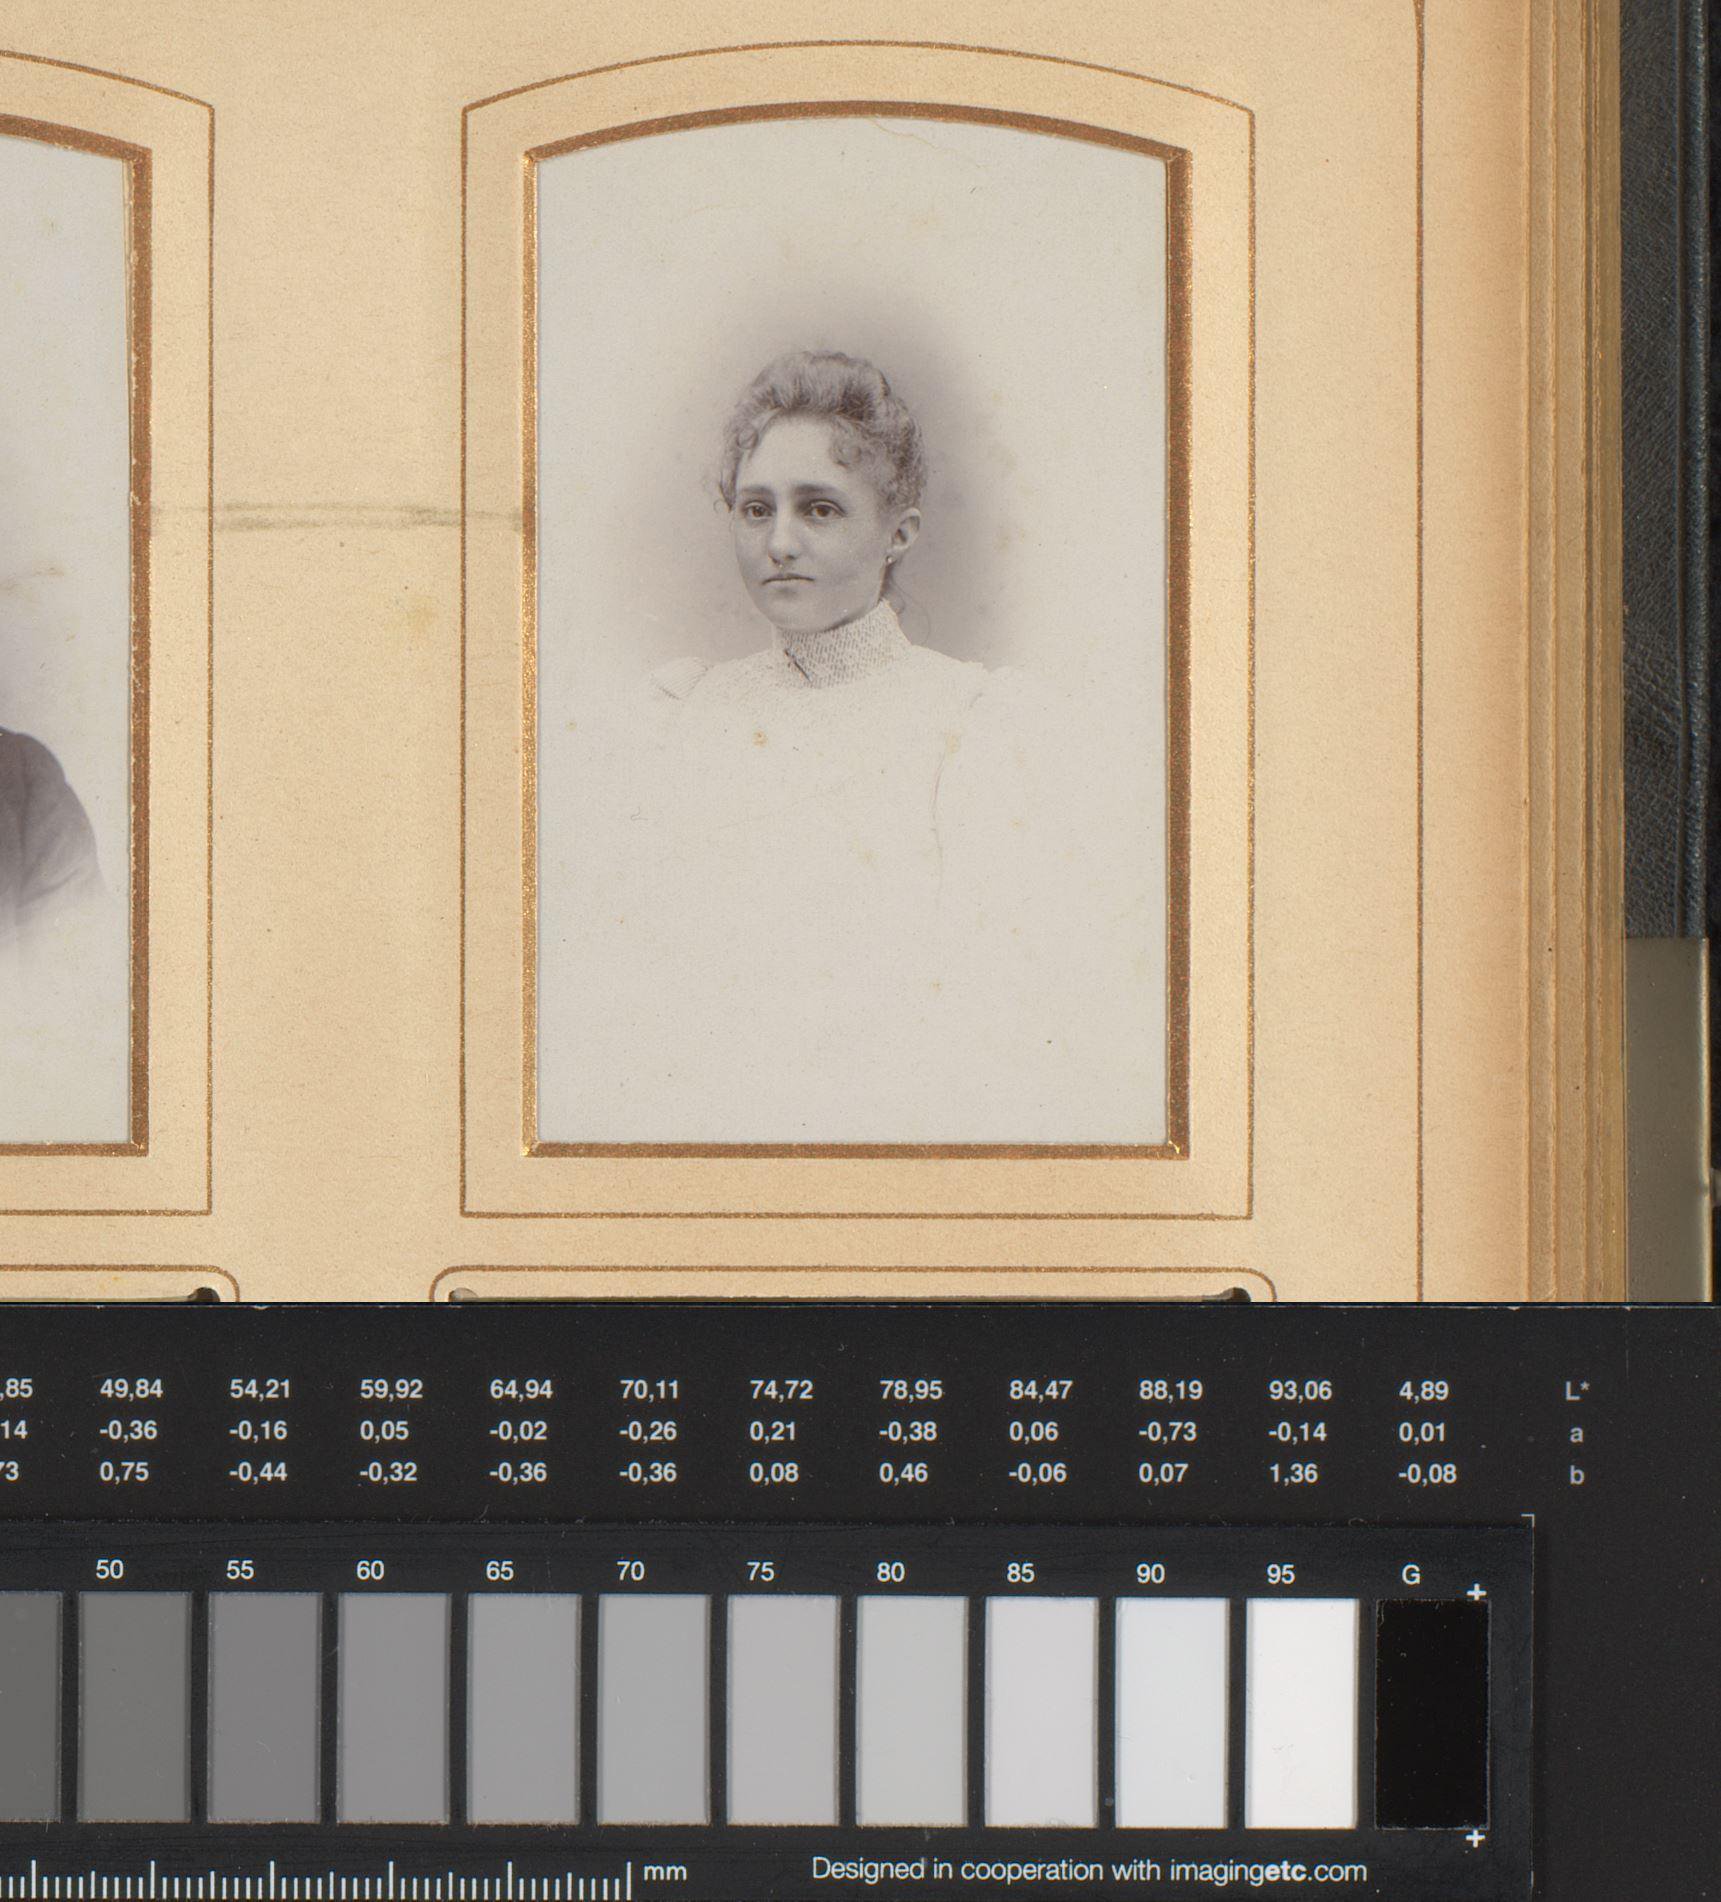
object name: photograph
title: Portret van een vrouw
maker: Anonymous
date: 1890-1920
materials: cardboard, photographic support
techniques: collodion silver print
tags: historical persons - bb - woman